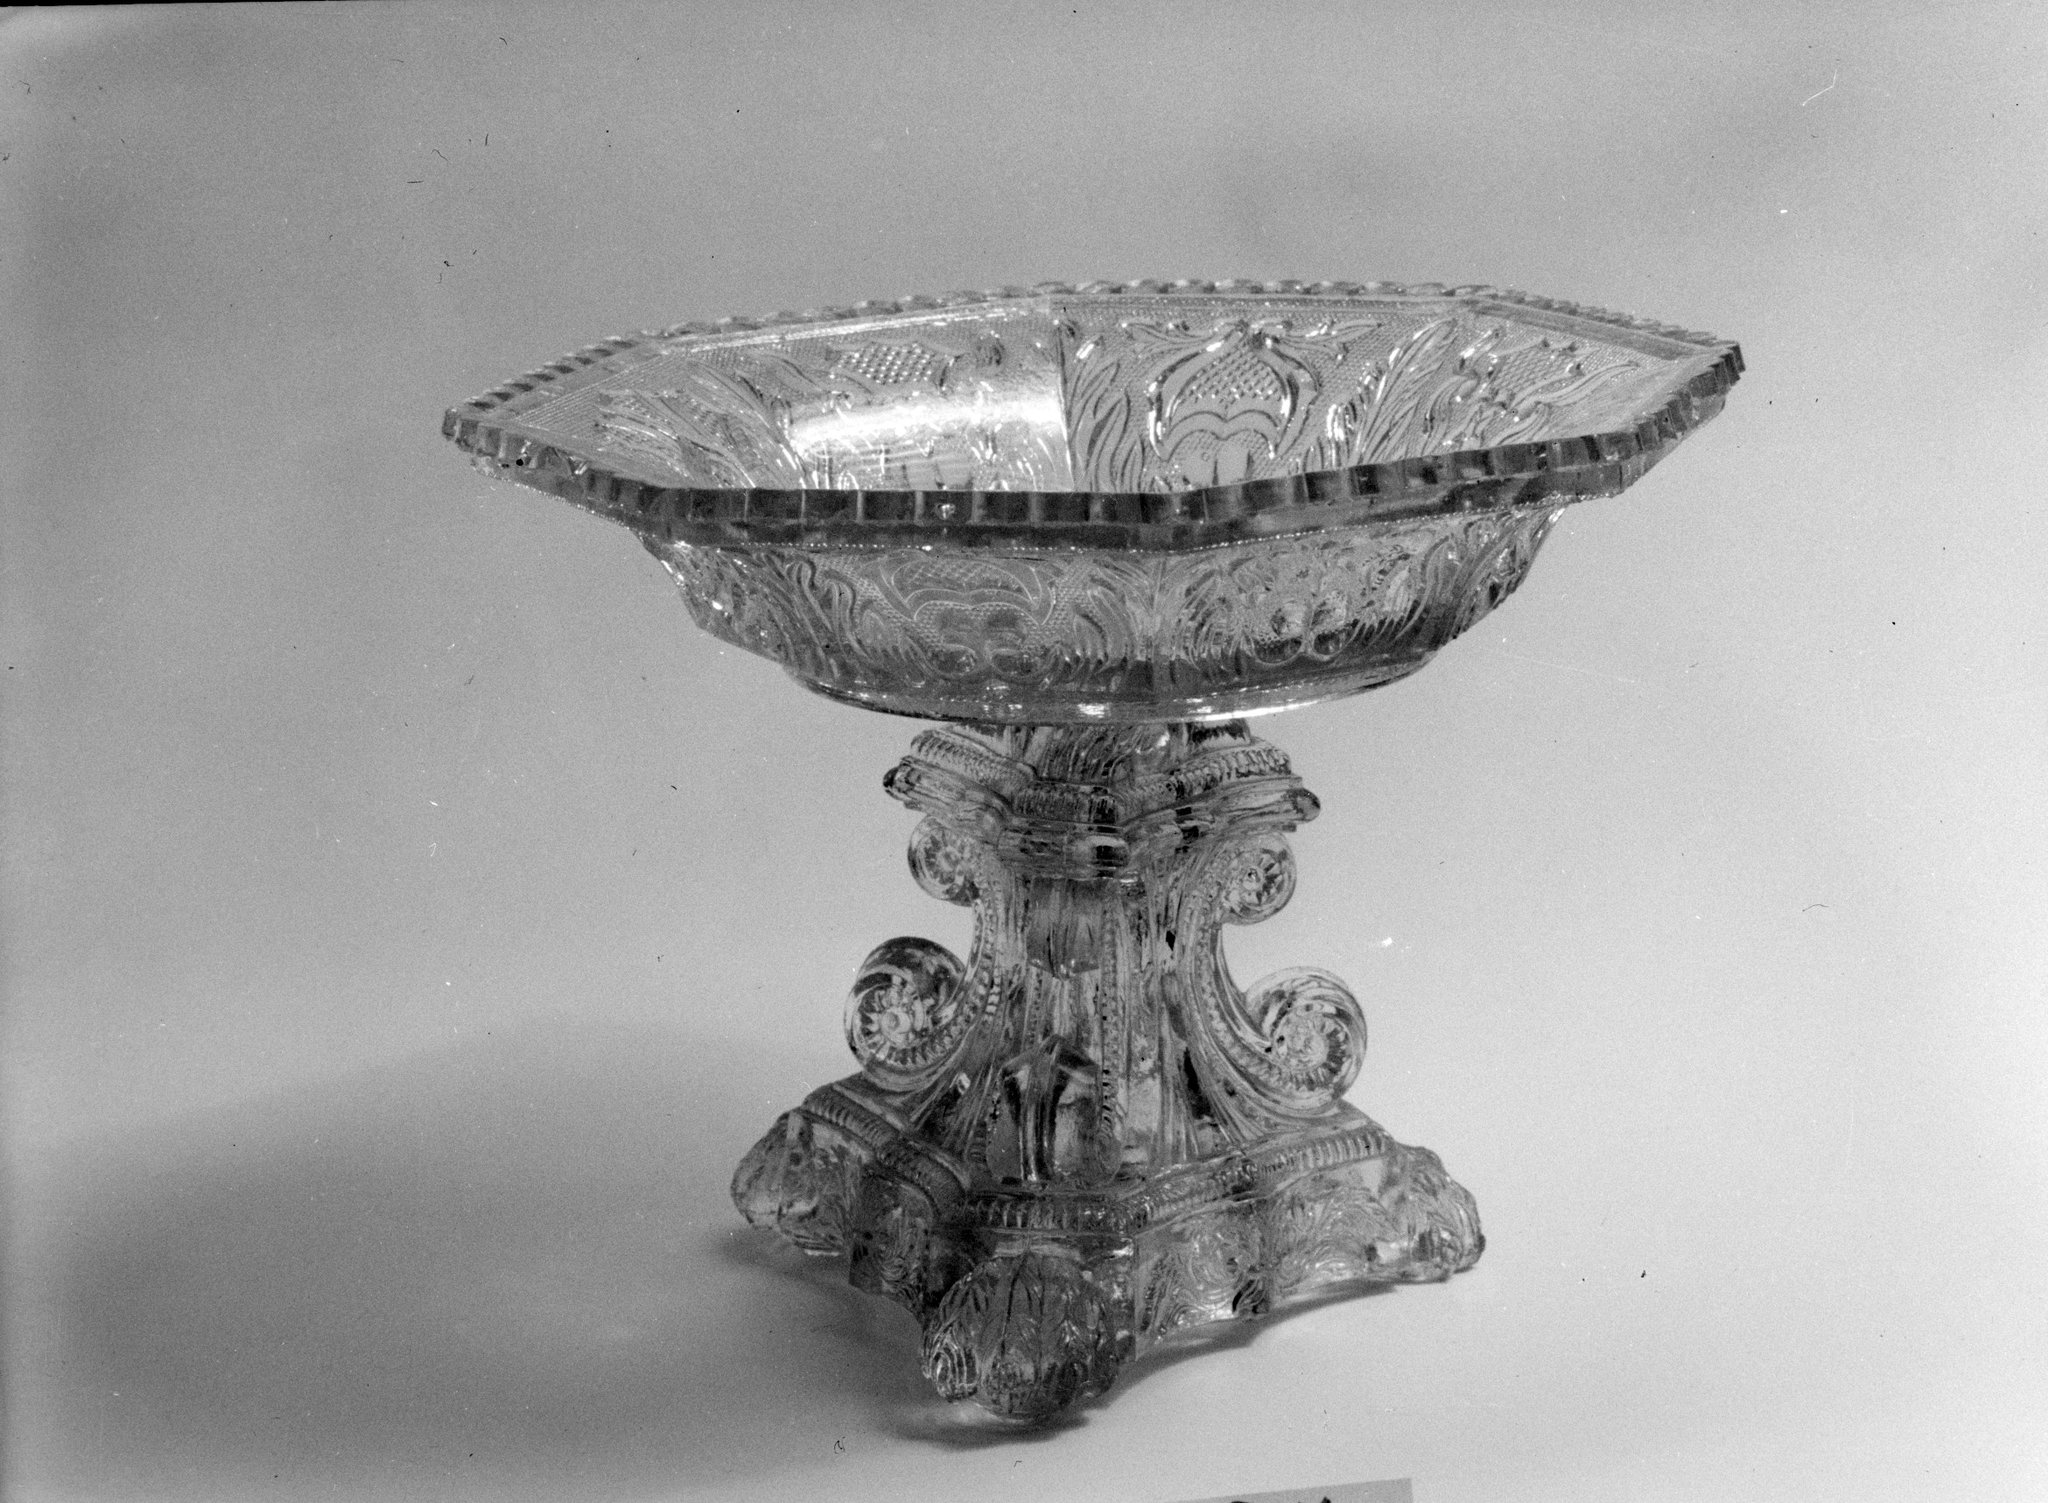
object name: compote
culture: american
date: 1835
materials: glass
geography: united states